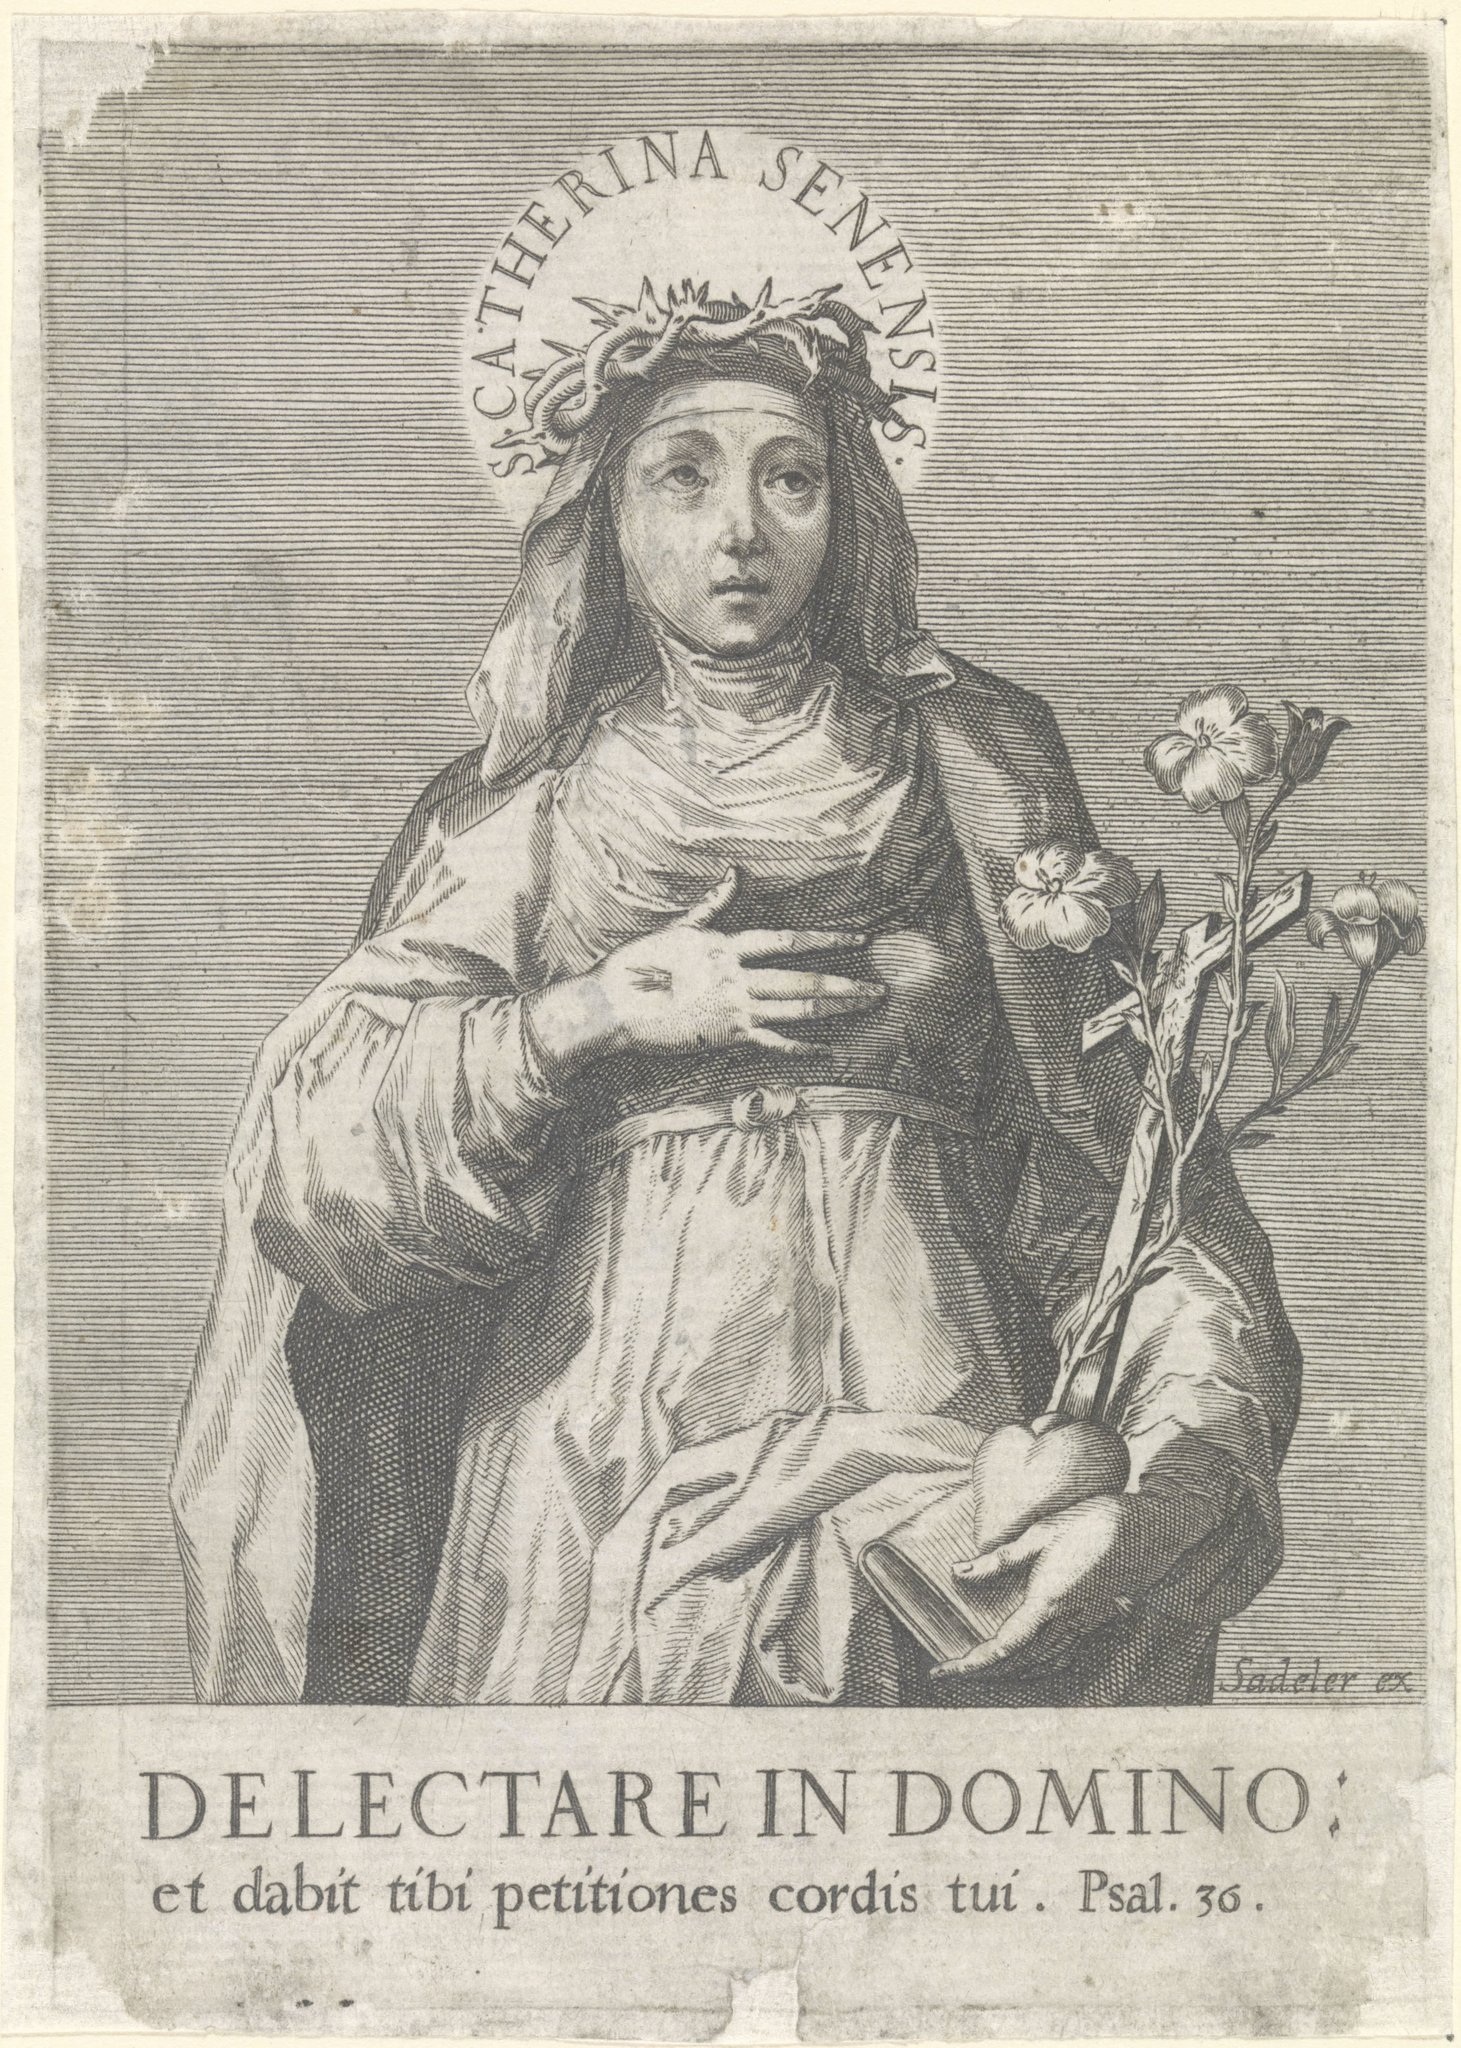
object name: print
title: Delectare in Domino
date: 1580-1600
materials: paper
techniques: engraving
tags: the virgin and dominican tertiary, catherine of siena; possible attributes: book, cross, crown of thorns, crucifix, demon under foot, heart (with cross), lily, plague-stricken, ring, rosary, stigmata - portrait of female saint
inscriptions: collector's mark: Lugt 2228, collector's mark: Lugt 2760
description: Deze prent heeft tot 1966 deel uitgemaakt van een prentalbum met op de rug de titel: Print Boeck van Justus Sadeler. Bij aankoop in 1966 bevatte het album 32 prenten. 18 bladen met prenten zijn uit het album verwijderd en opgenomen in de collectie van het Rijksprentenkabinet. Zie voor dit album het gerelateerd object.